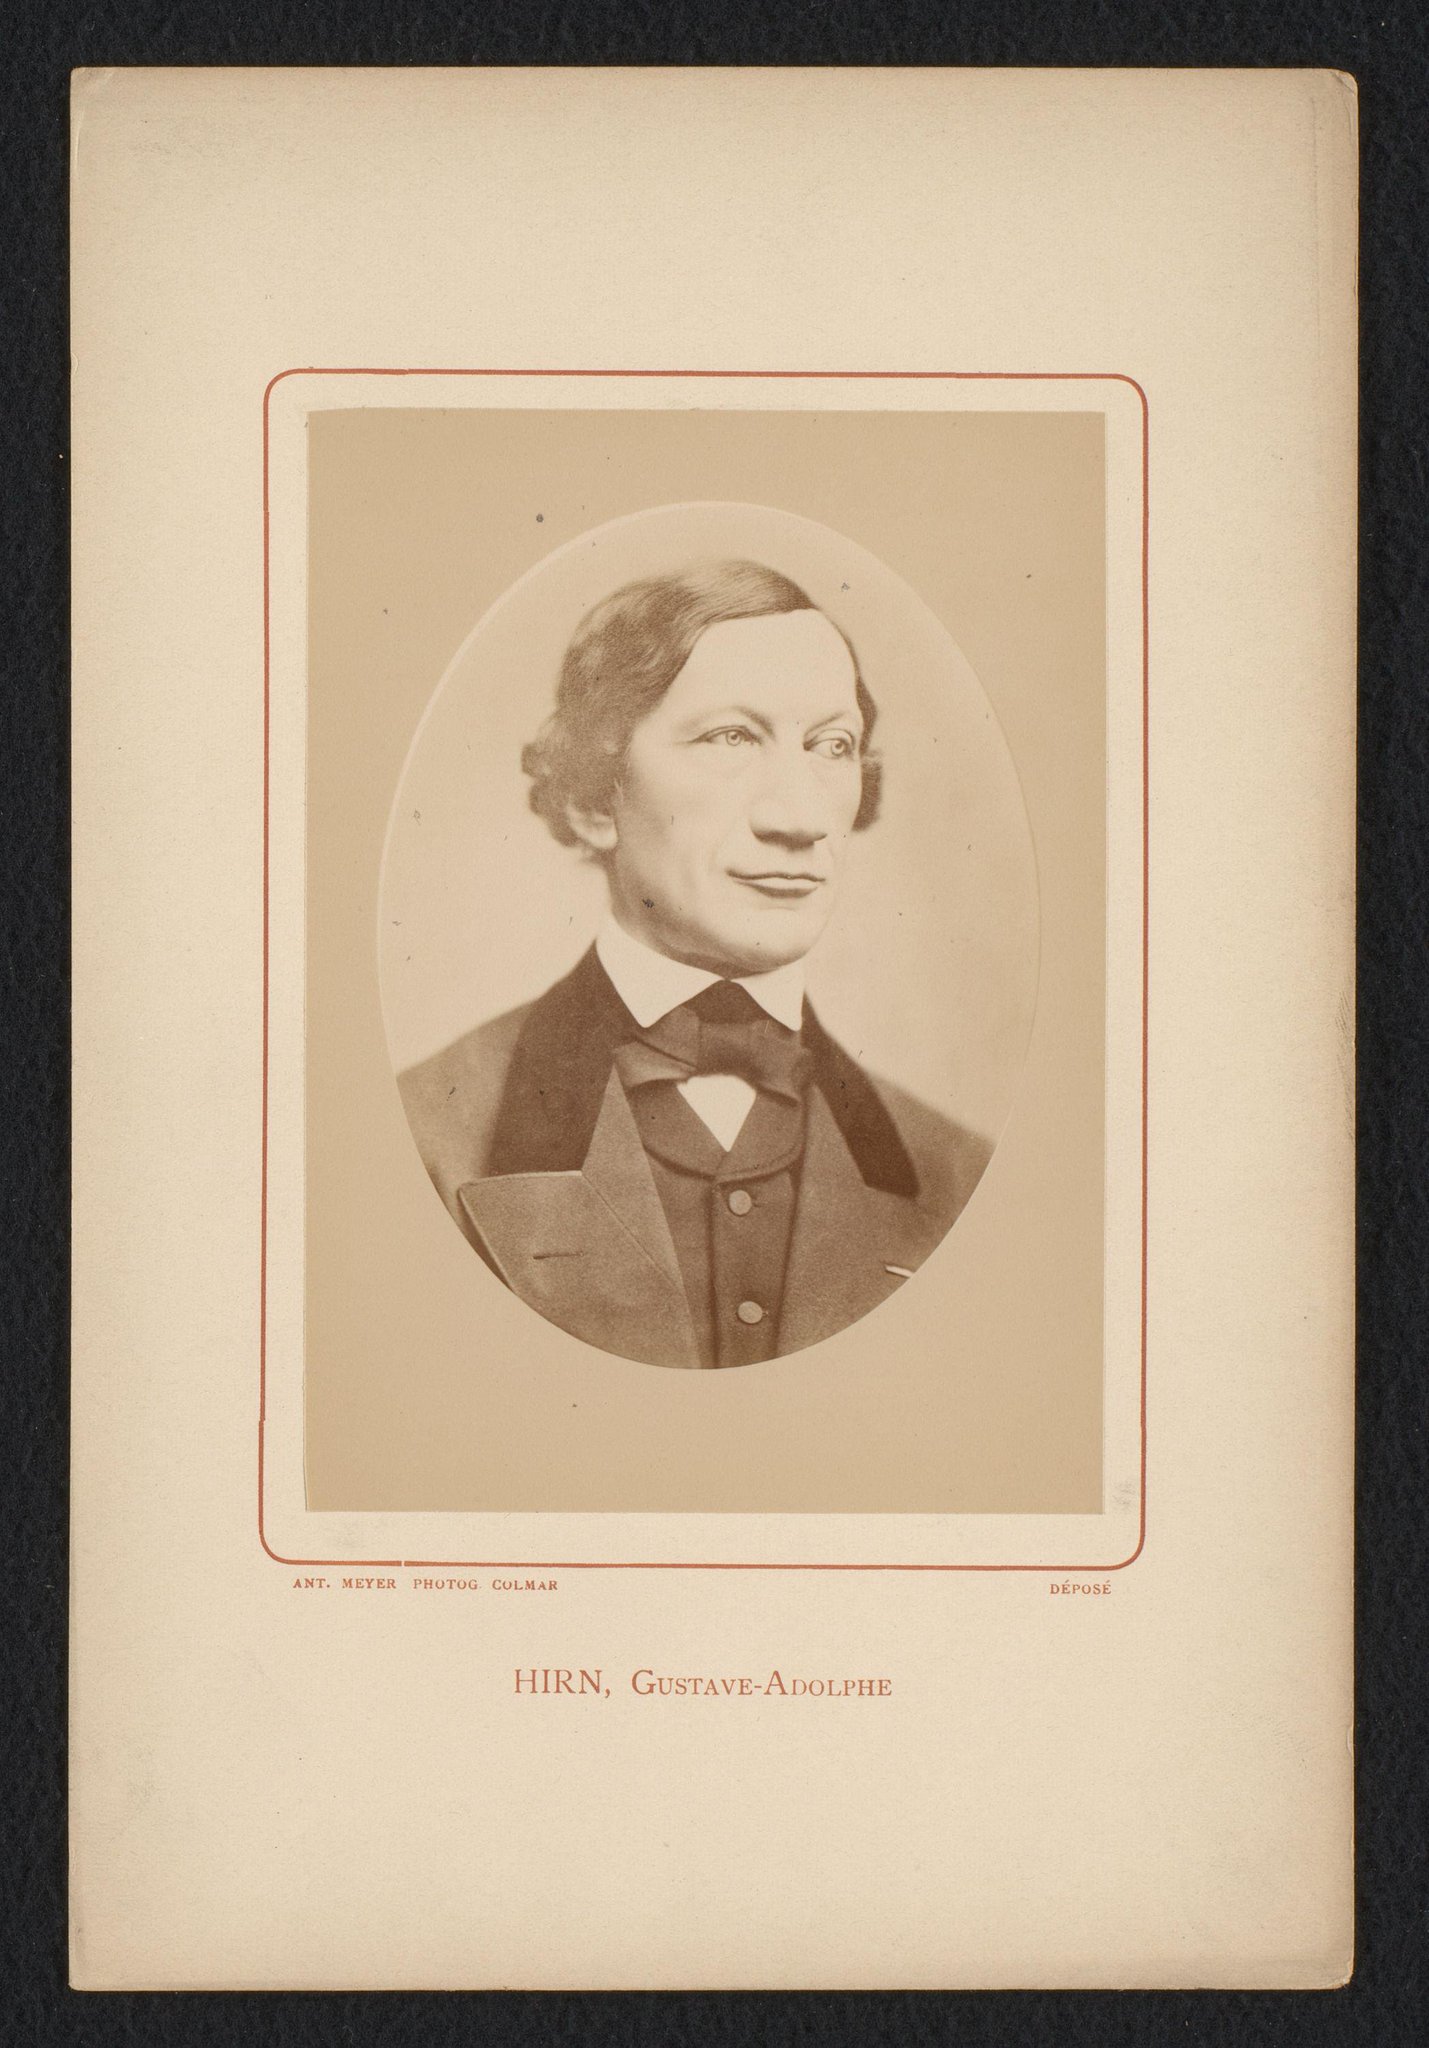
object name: photograph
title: Portret van Gustave-Adolphe Hirn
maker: anton meyer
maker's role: fotograaf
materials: photographic support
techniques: albumen print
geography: colmar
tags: physicist, historical persons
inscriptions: inscription: ‘Déposé’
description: Deze foto maakt deel uit van een omslag met 29 foto's op 29 bladen en 23 teksbladen.